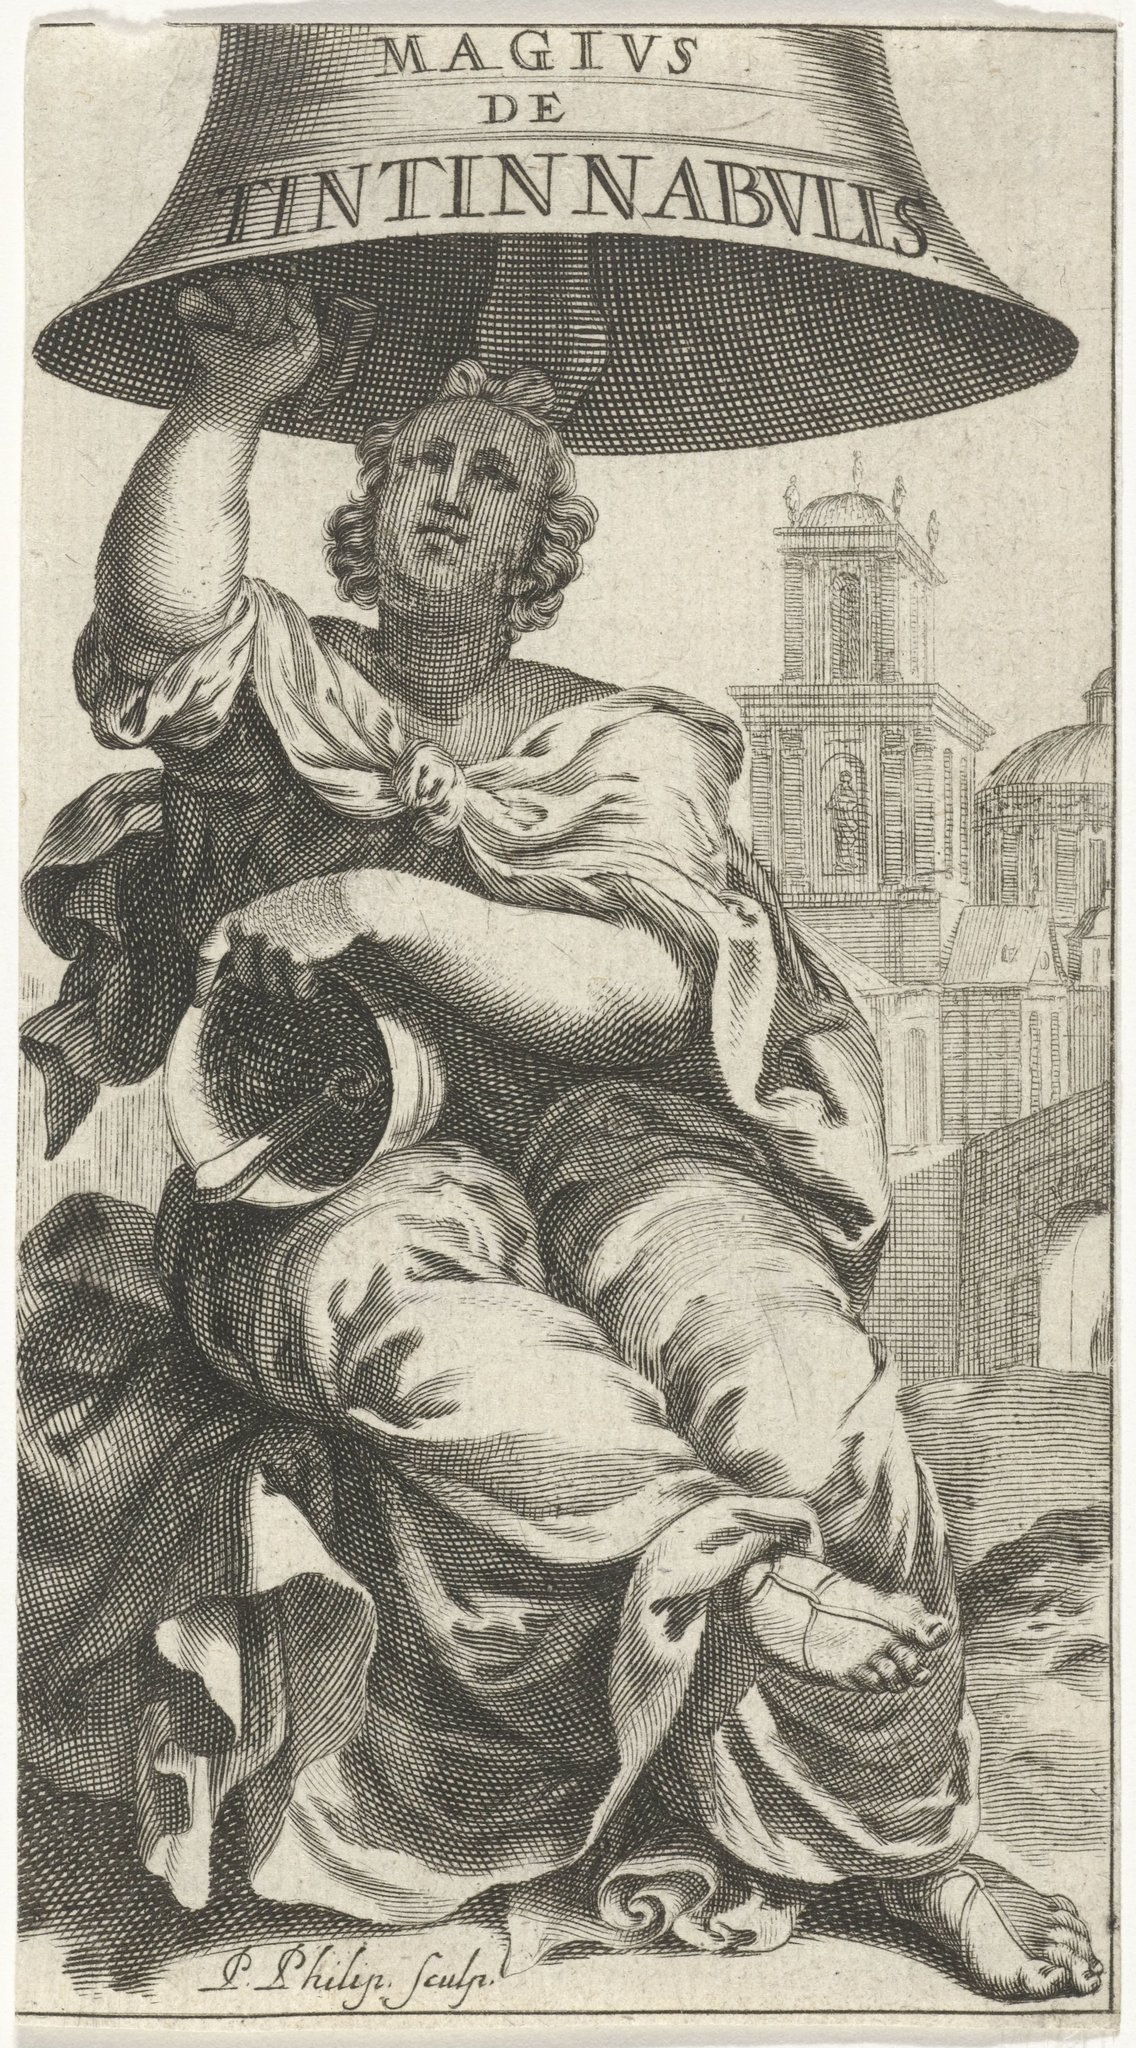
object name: titelblad, titelpagina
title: Titelpagina voor: G. Maggi, De tintinnabulis liber postumus, 1664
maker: pieter philippe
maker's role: print maker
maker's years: 1635-1702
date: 1664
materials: paper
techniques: engraving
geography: northern netherlands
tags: church bell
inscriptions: collector's mark: Lugt 2228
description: Landschap met een vrouw die onder een bel zit waarop de titel "De tintinnabulis liber postumus". Met een hamer slaat ze tegen de bel. Op haar schoot een kleinere bel.